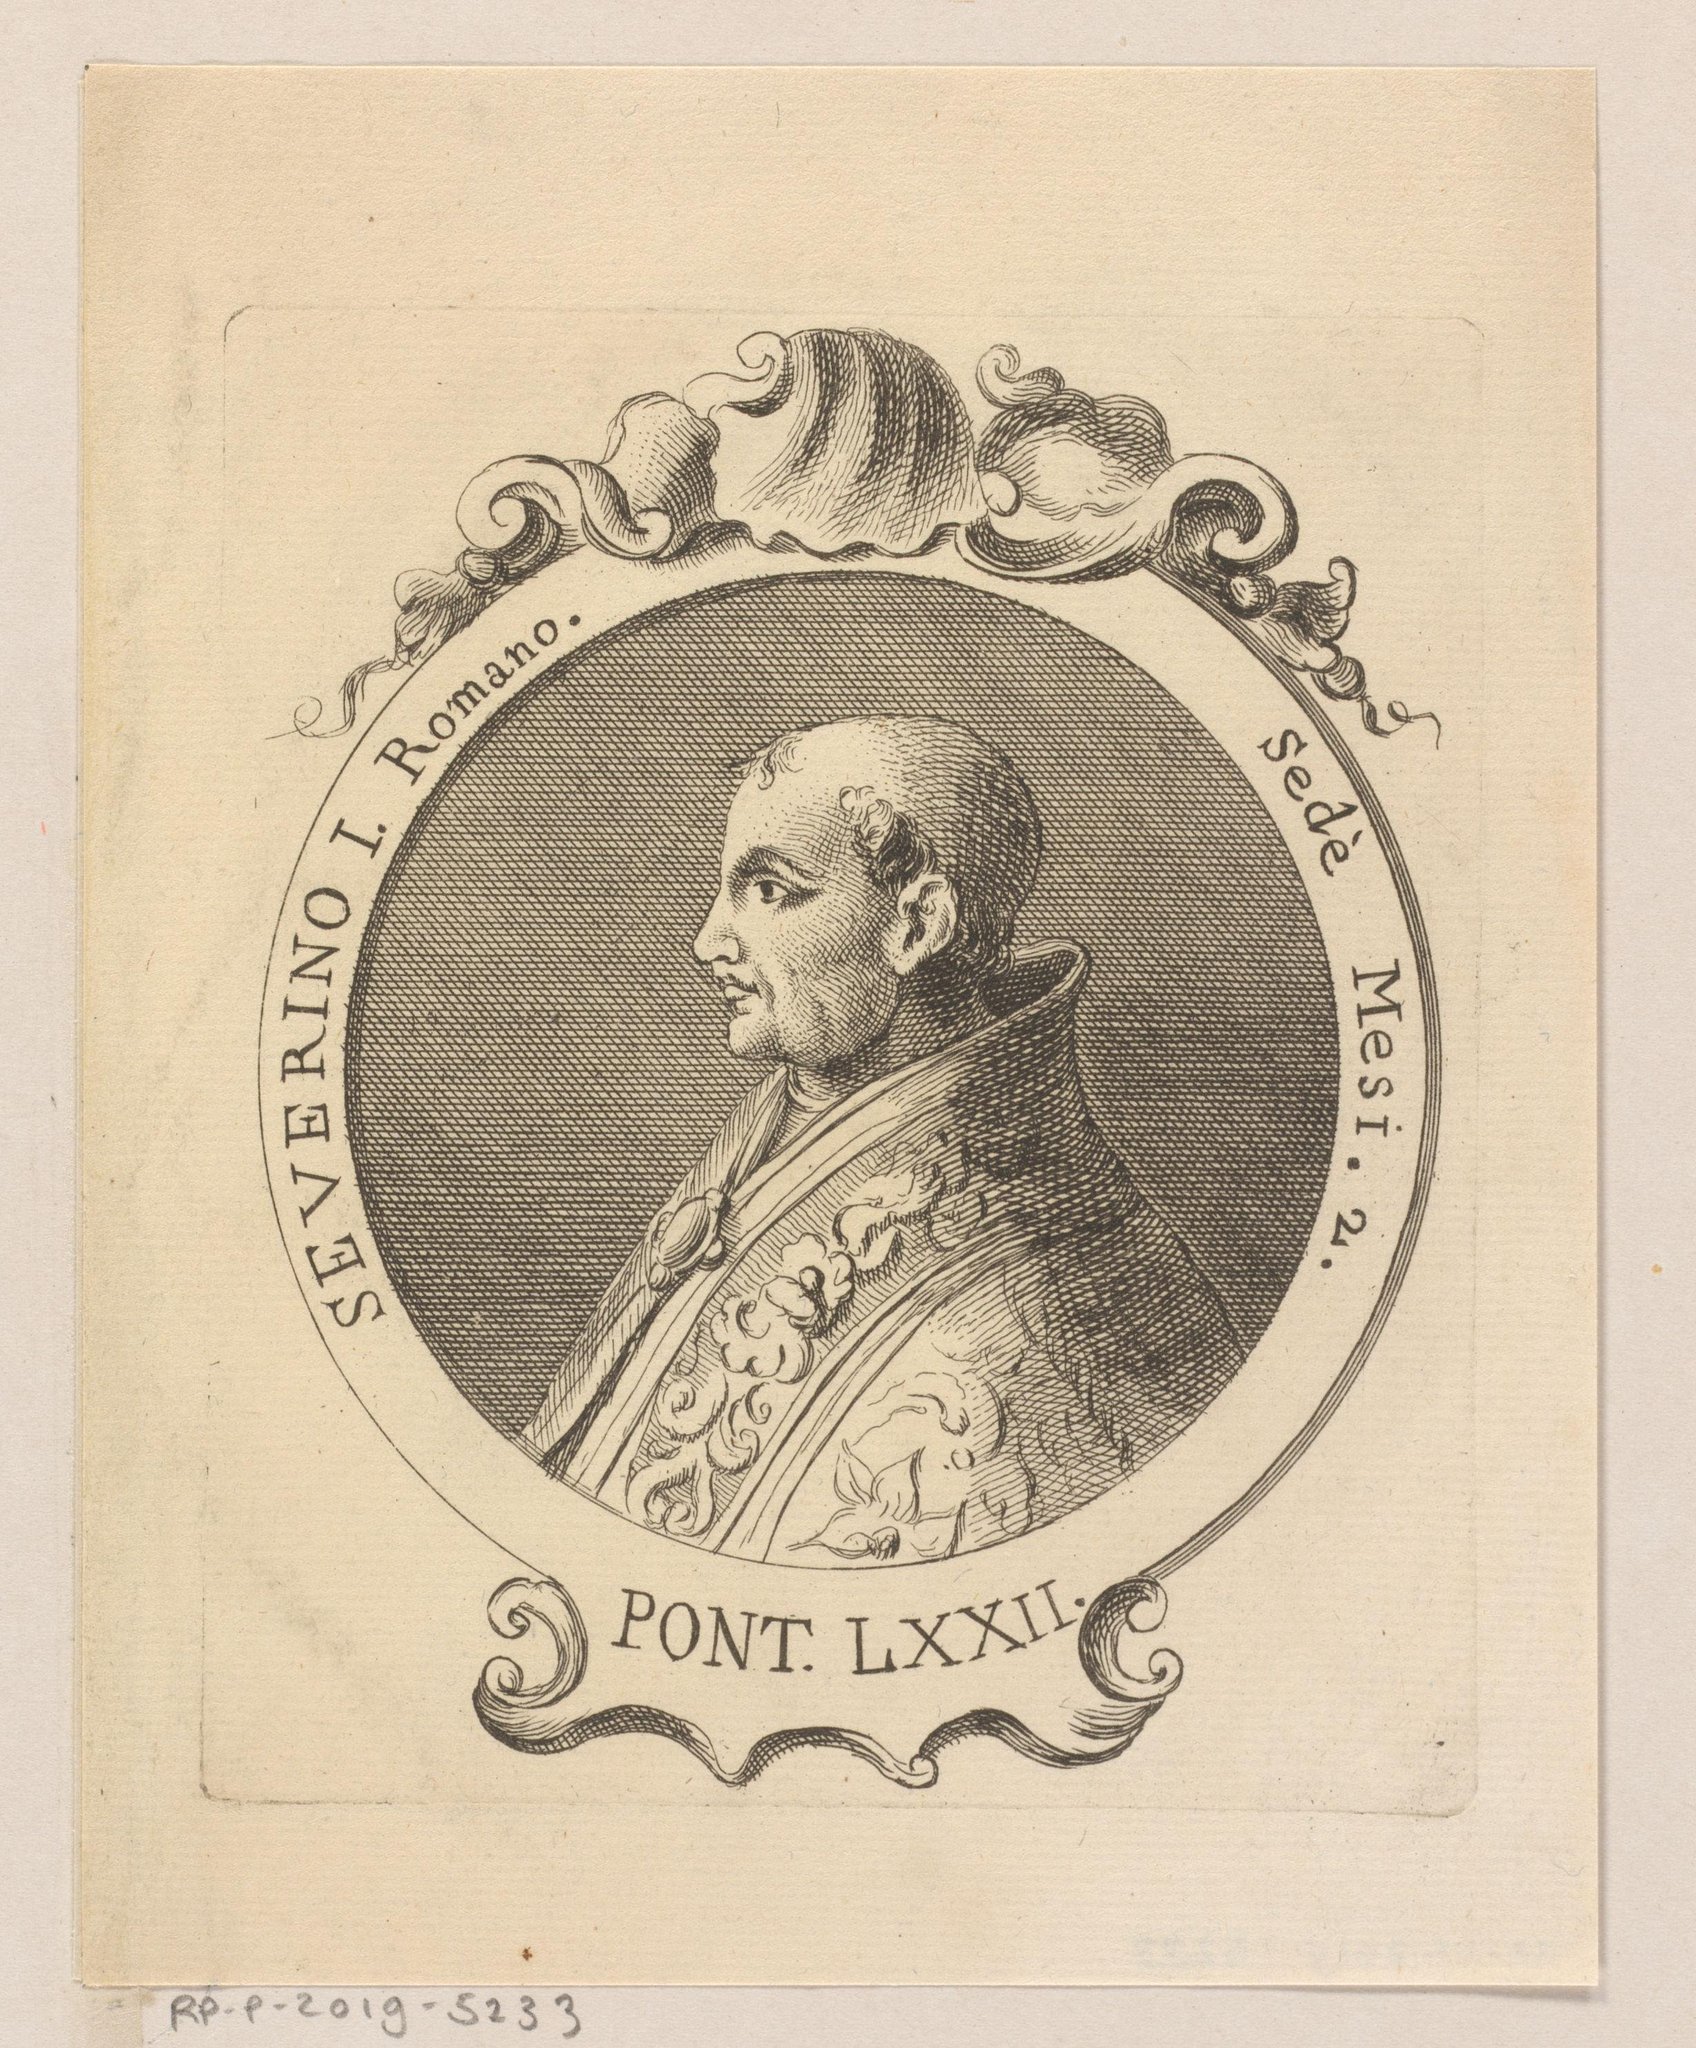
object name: print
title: Portret van paus Severinus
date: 1775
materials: paper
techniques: etching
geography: bassano del grappa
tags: historical persons, pope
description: Prent uit: Effigies Romanorum pontificum a S. Petro ad Pium VI. feliciter regnantem (...). 2 dln. Venetië en Bassano del Grappa: Giuseppe Remondini, 1775.